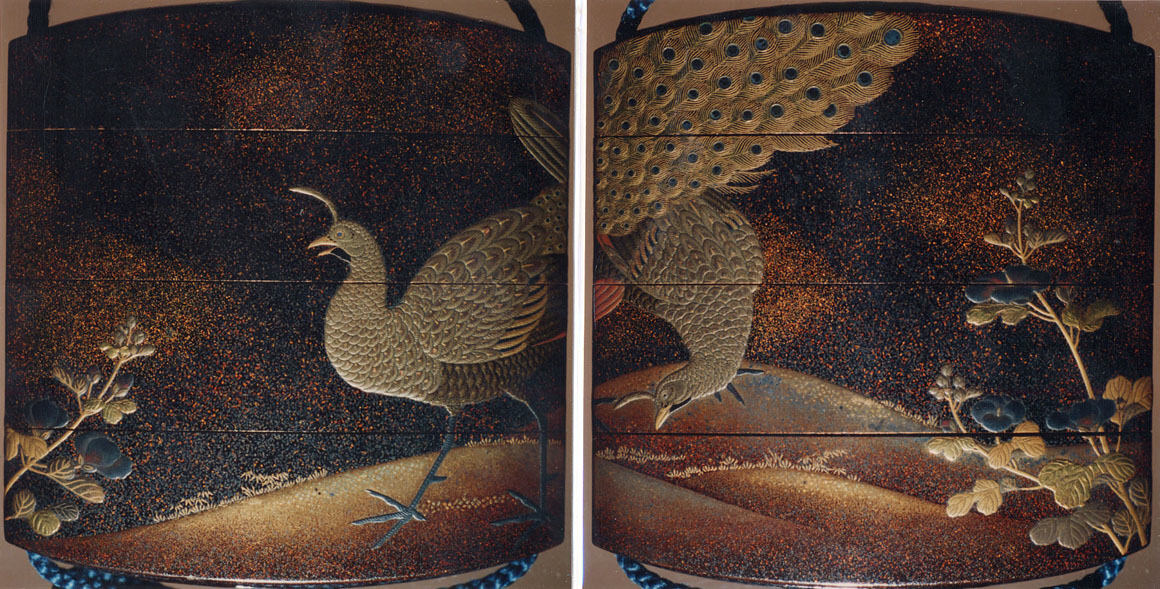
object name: inrō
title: Case (Inrō) with Design of Peacock and Pea Hen beside Flowering Malvern Plants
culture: japanese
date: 1801-1900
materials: gold, lacquer, silver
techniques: fundame, hiramakie, roiro, maki-e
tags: peacocks,flowers,plants